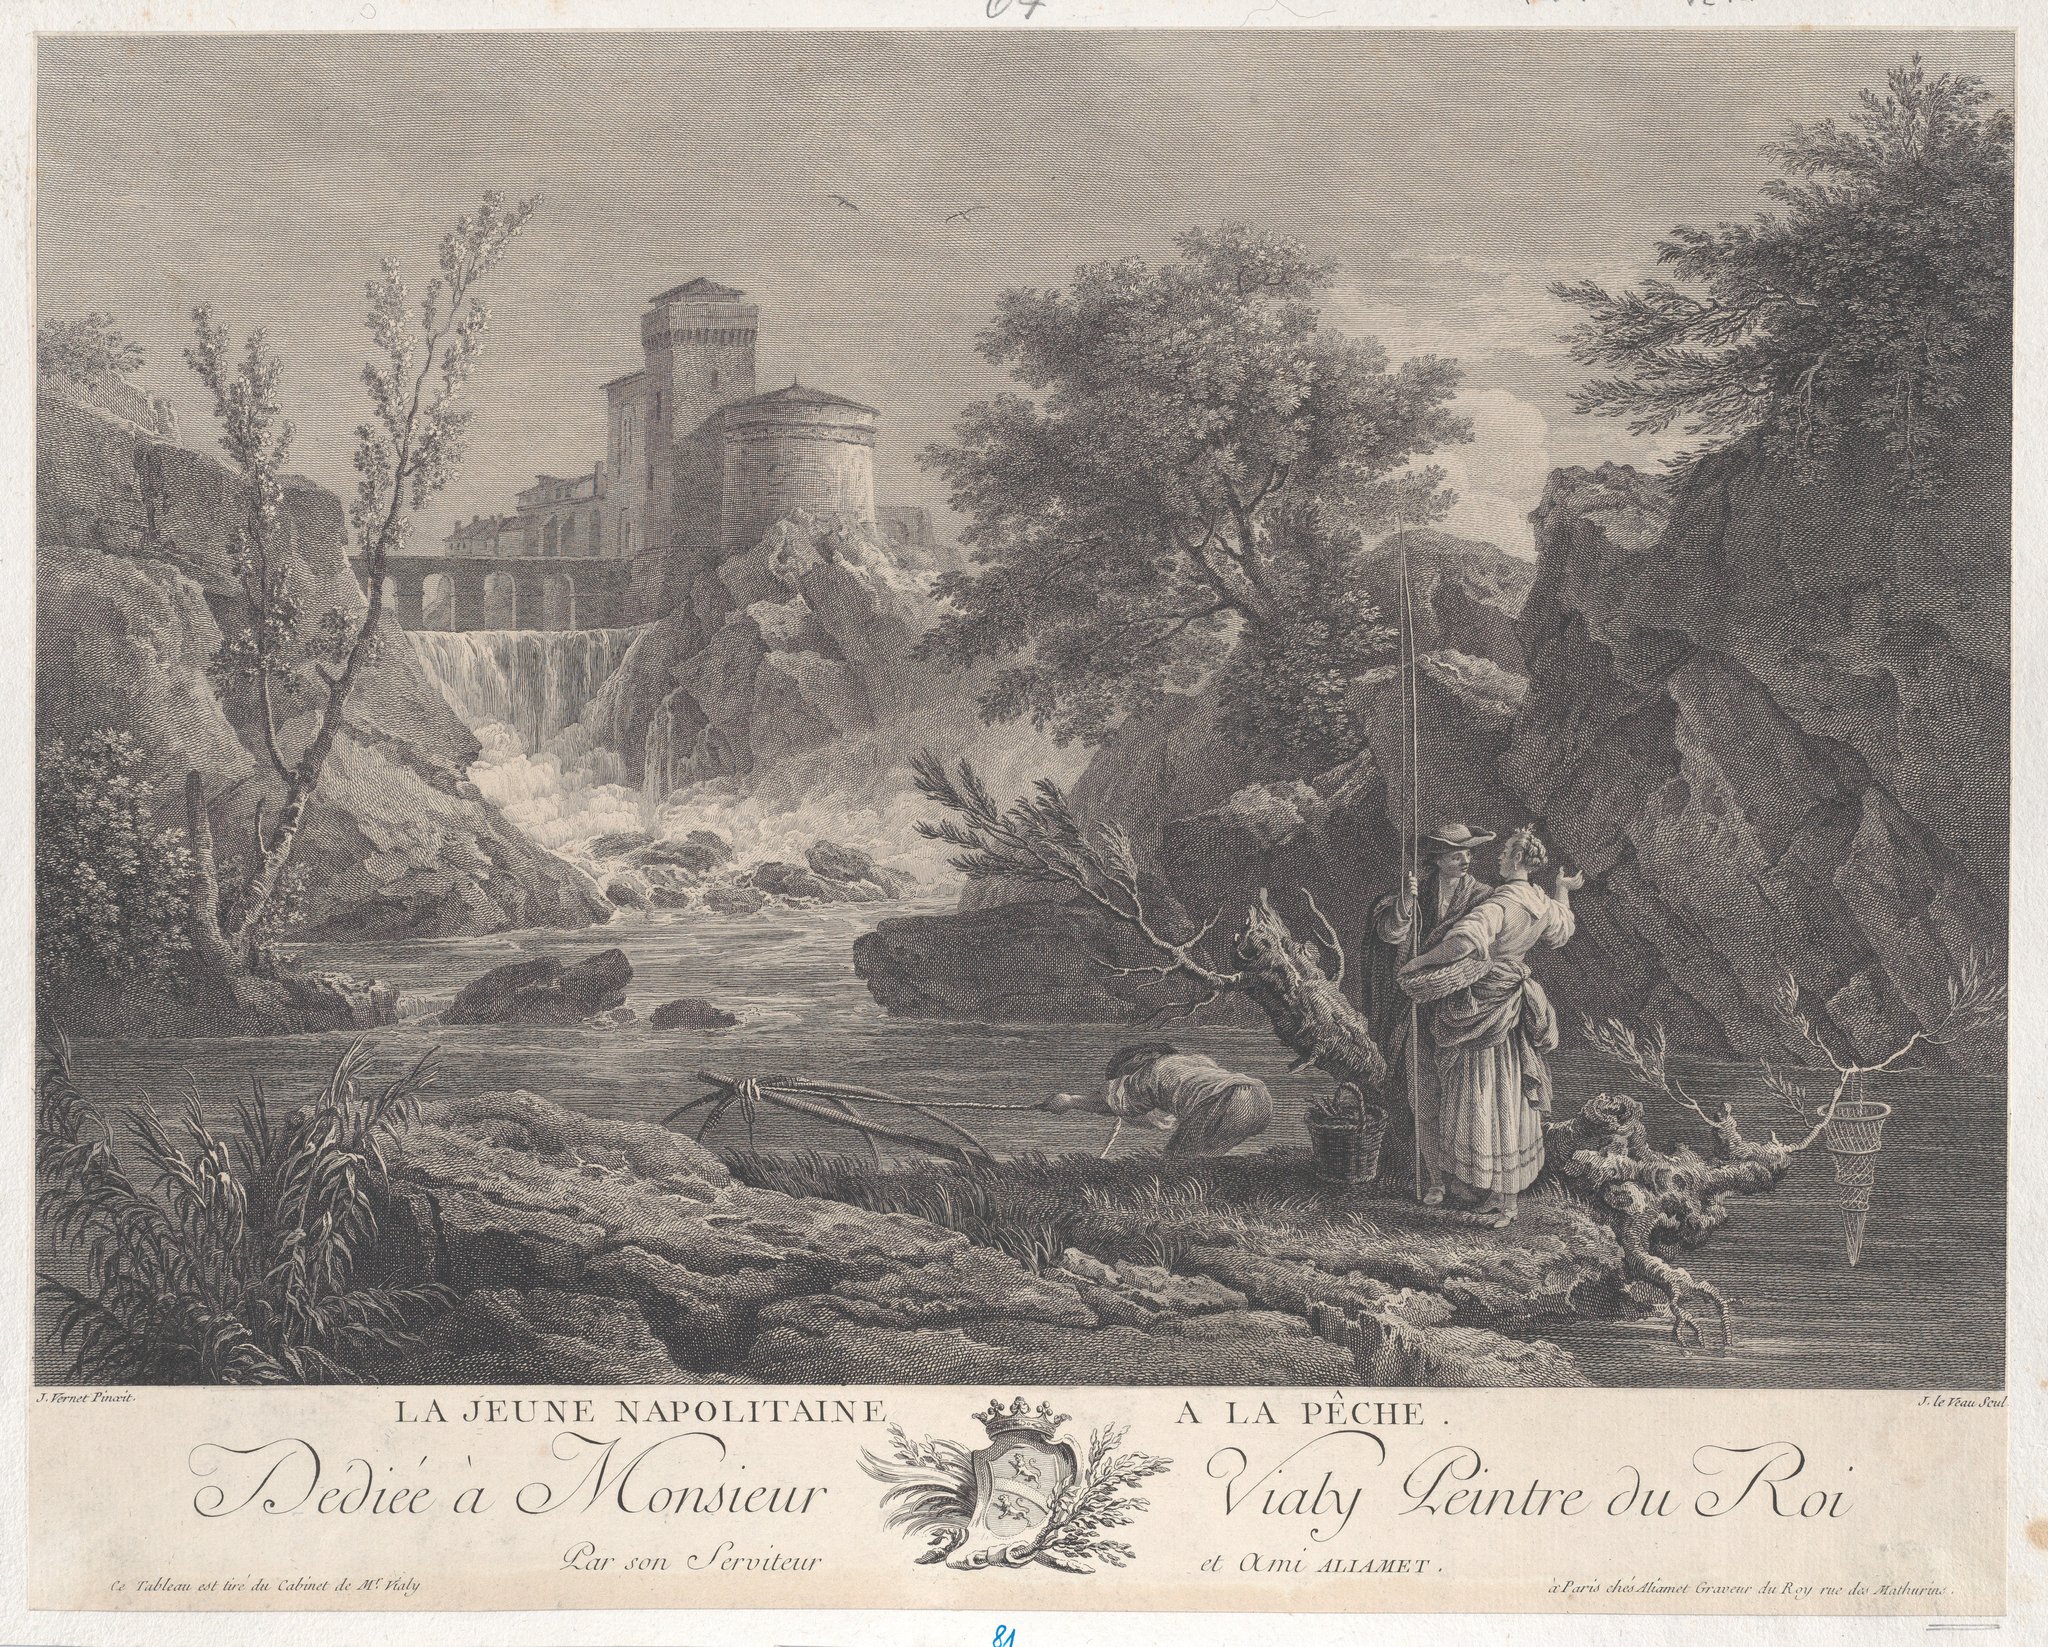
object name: print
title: Young Neapolitan Woman Fishing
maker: joseph vernet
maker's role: artist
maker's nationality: french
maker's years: 1714-1789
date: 1770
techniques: engraving